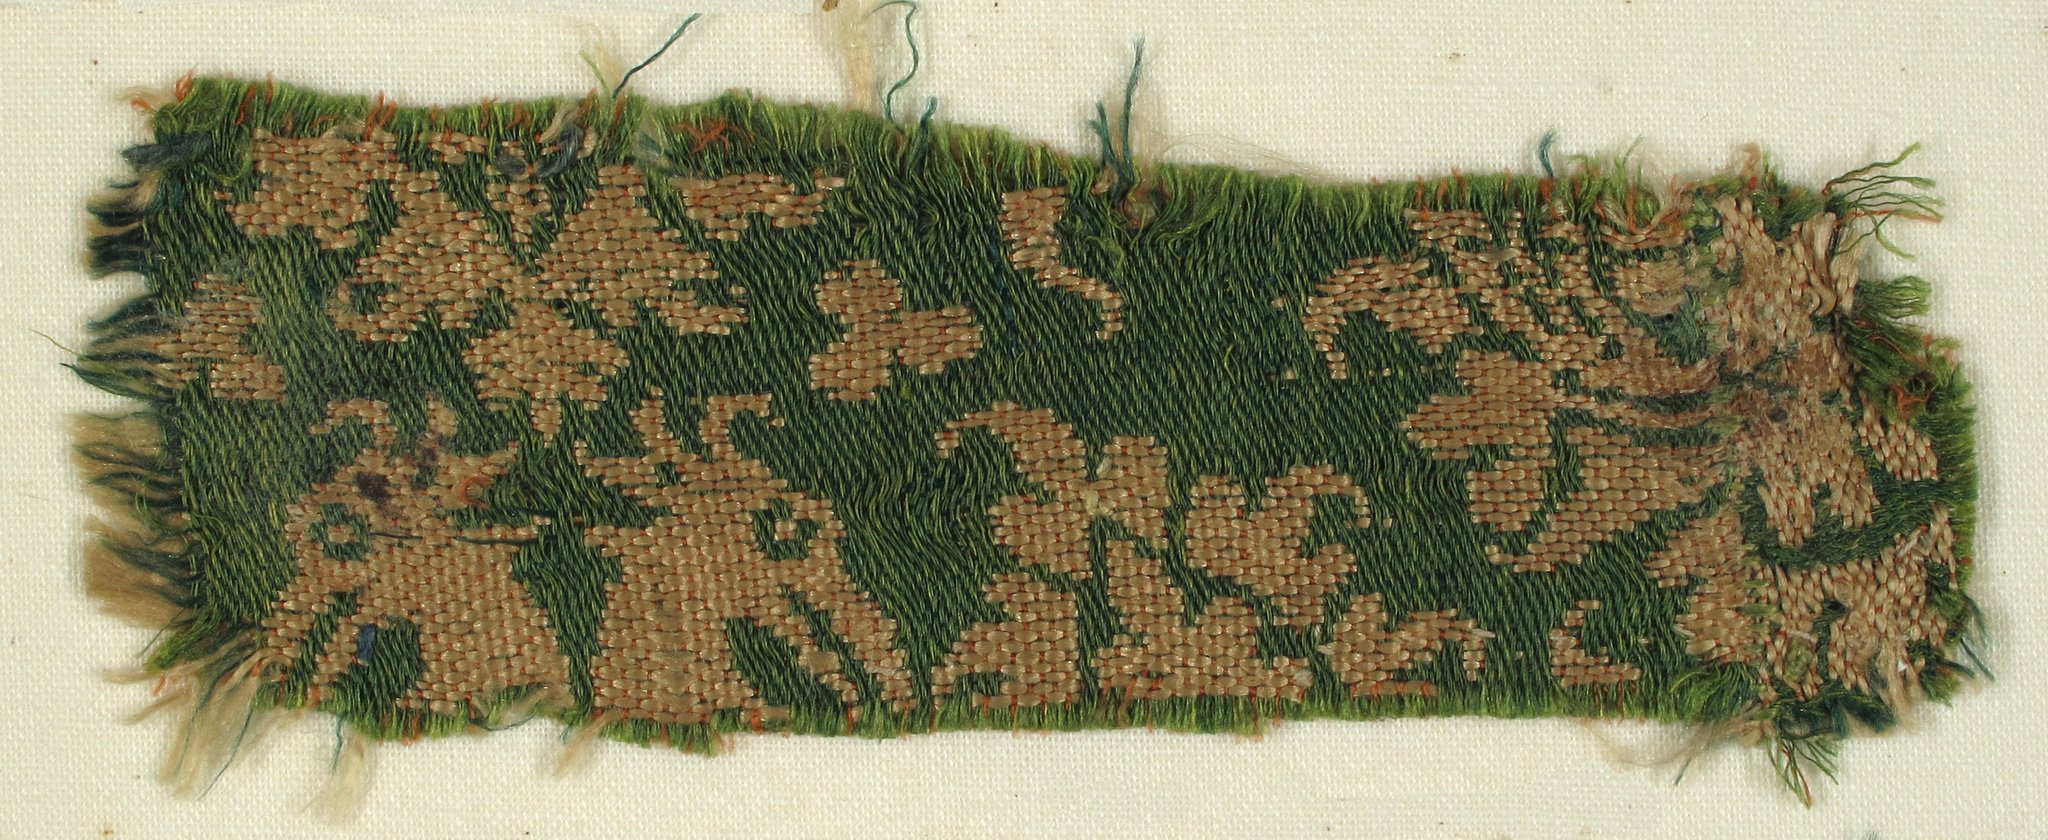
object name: textile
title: Textile with Figures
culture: italian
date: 1301-1400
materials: silk